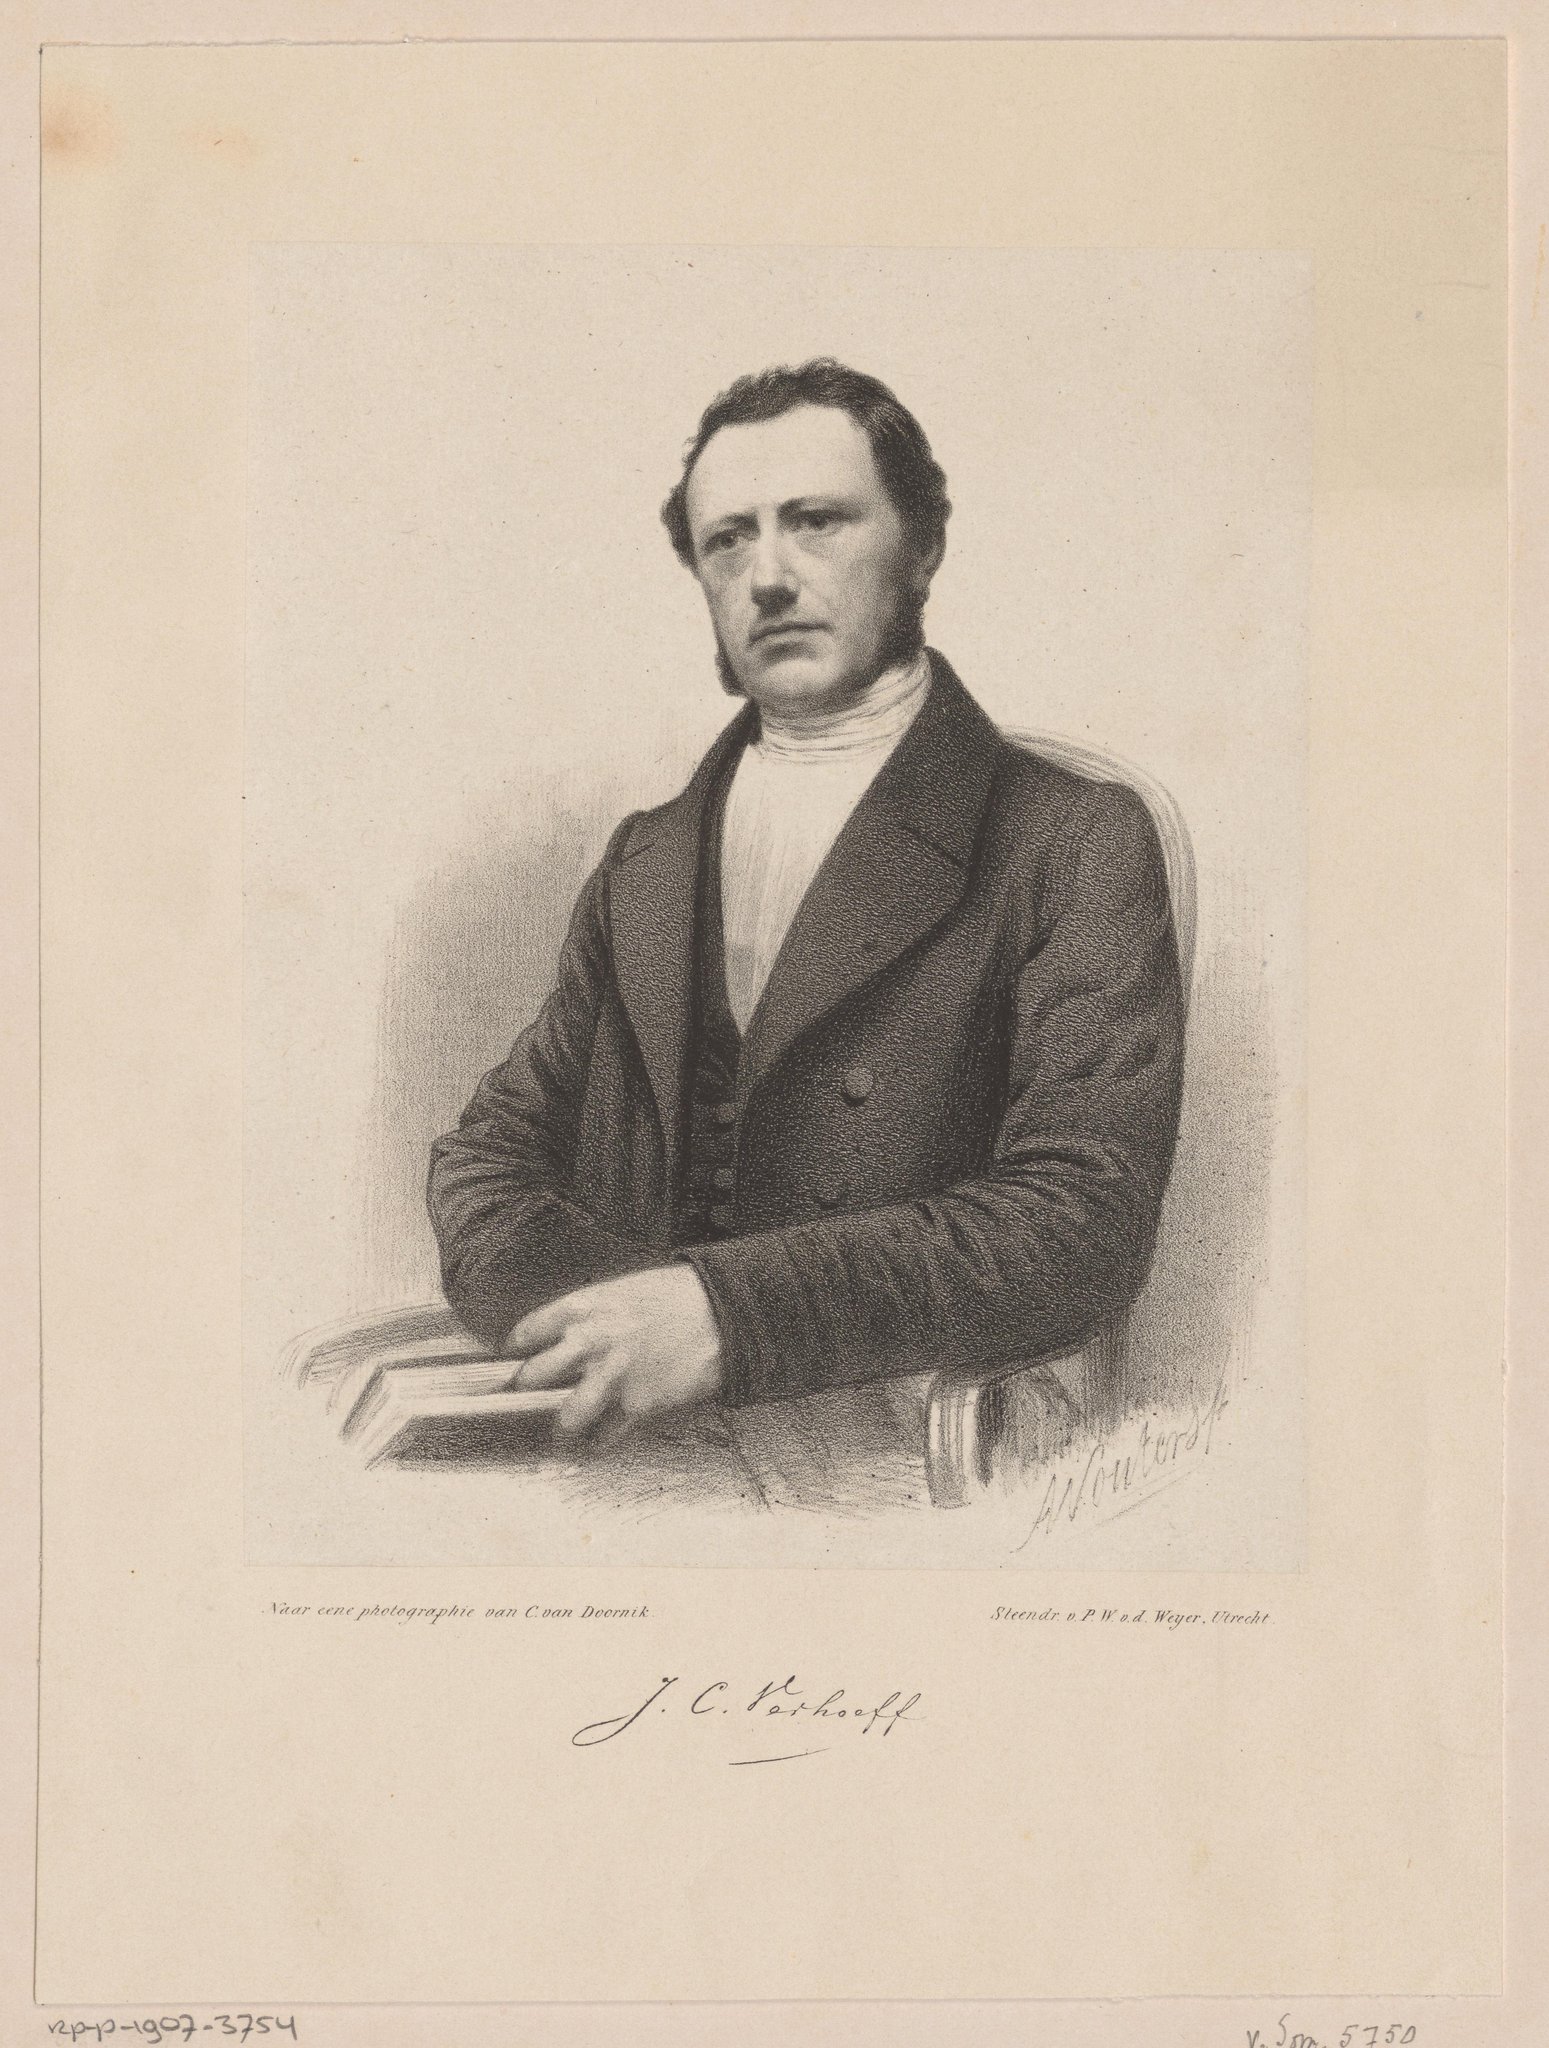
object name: print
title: Portret van Jacobus Gerardus Verhoeff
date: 1850-1870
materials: paper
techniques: lithograph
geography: utrecht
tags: utrecht, bodegraven, theologian, historical persons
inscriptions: collector's mark: Lugt 2228